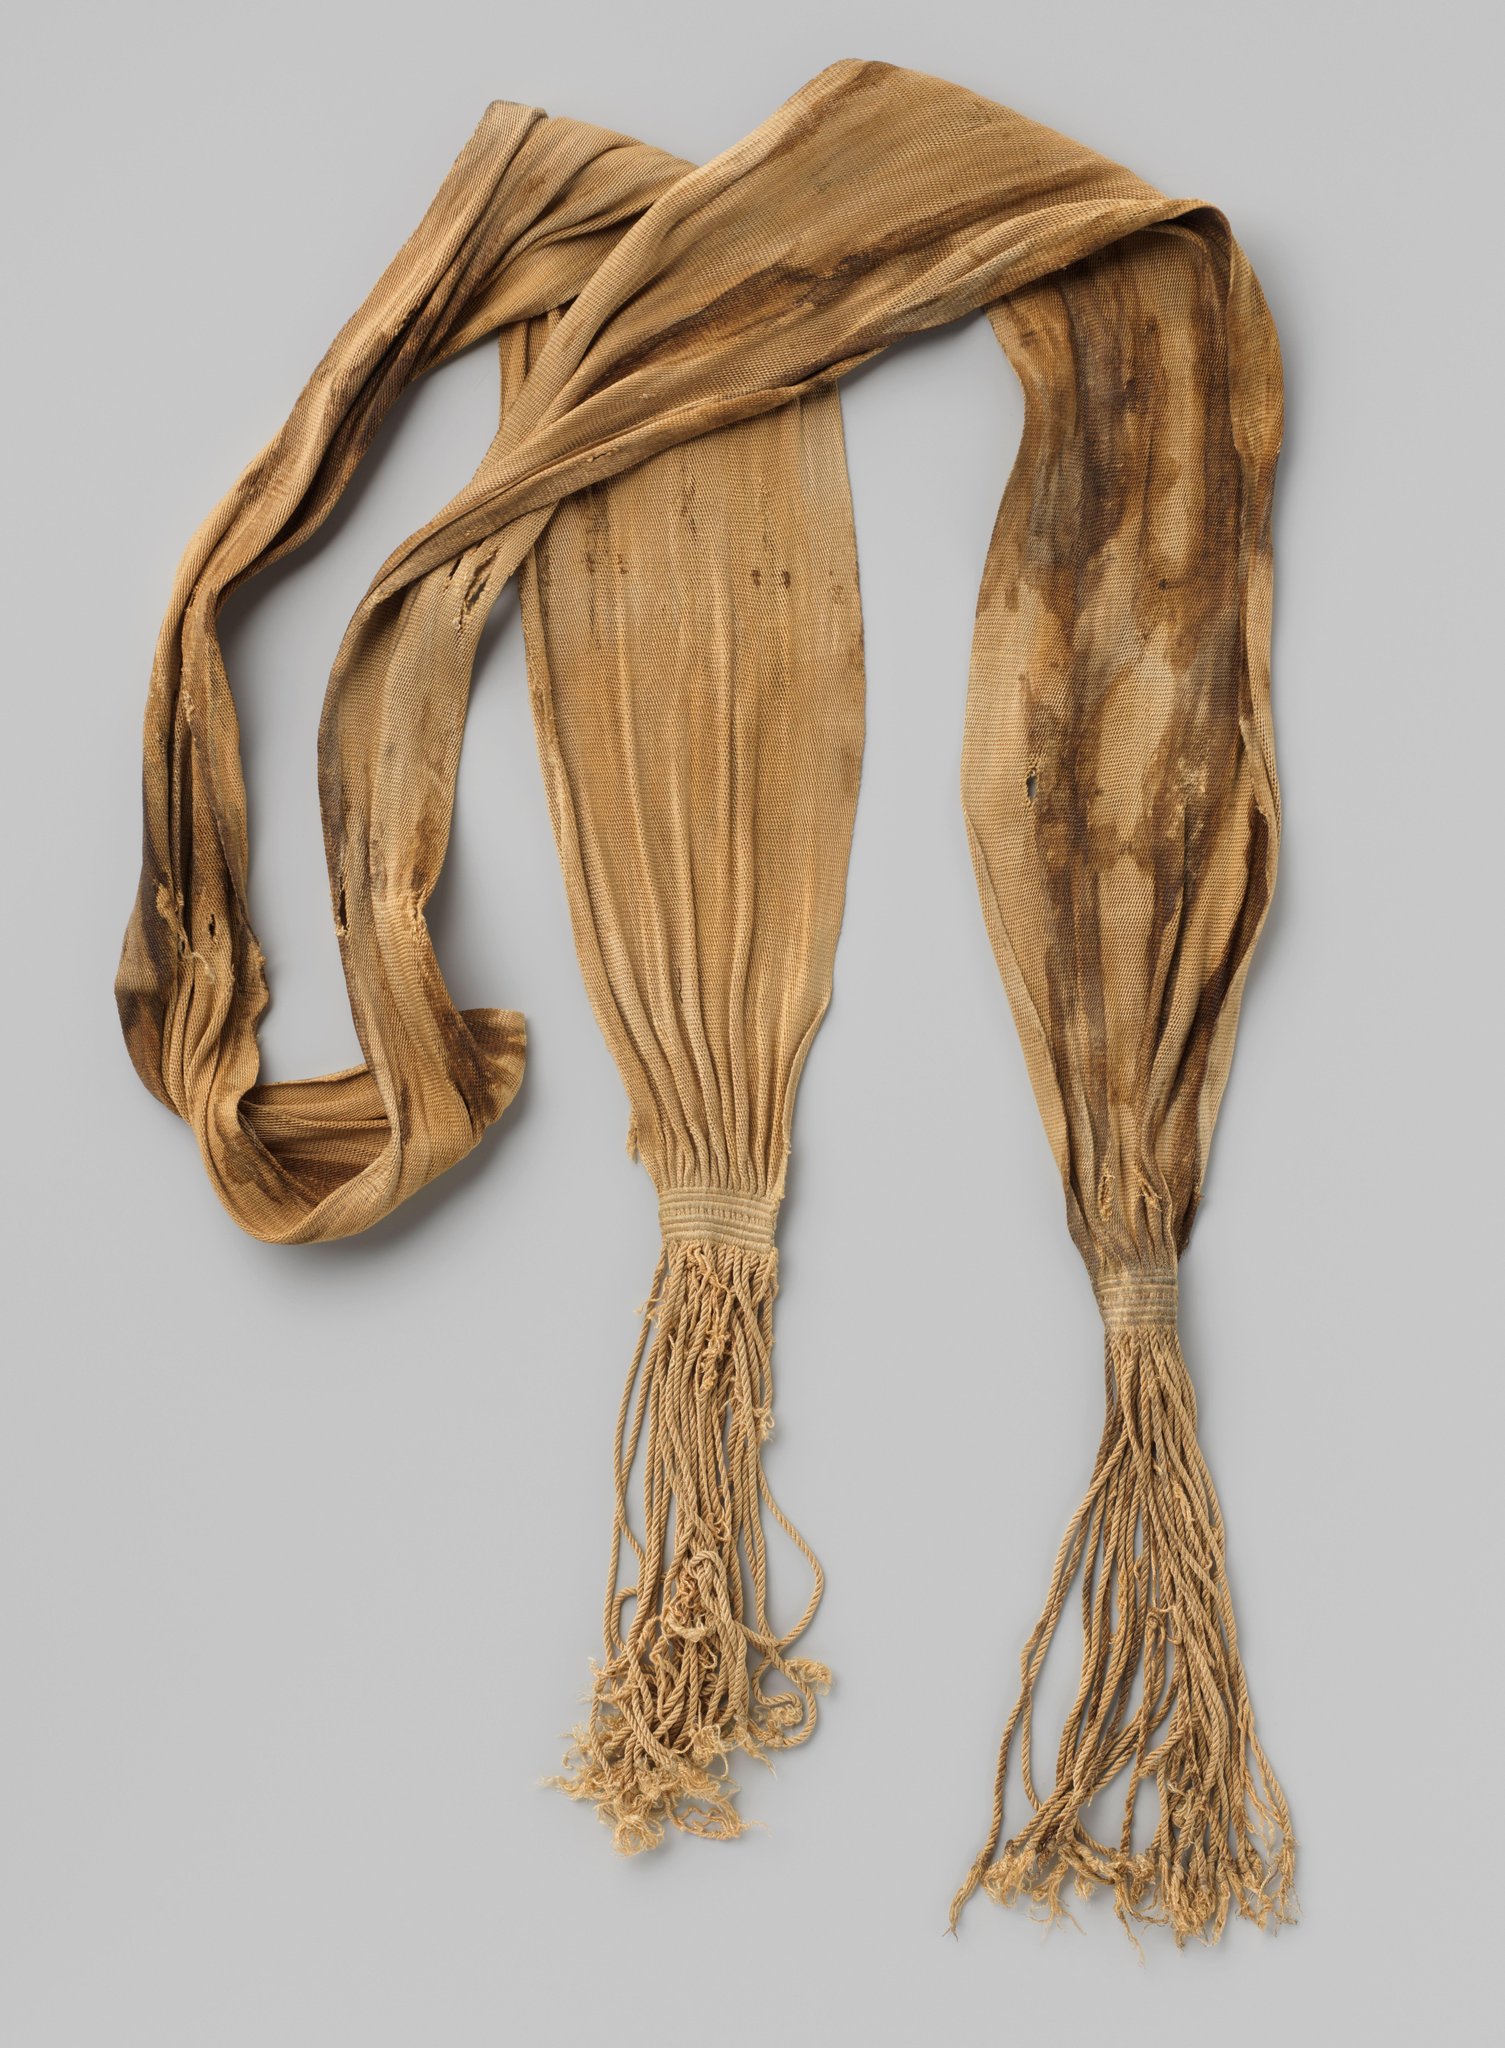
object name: sash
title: Sjerp gedragen door kapitein van Hoeg Schilthouwer van Oostee, gesneuveld op de citadel van Antwerpen op 13 December 1832.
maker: Anonymous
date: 1800-1830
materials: blood, silk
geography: netherlands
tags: van hoeg schilthouwer van oostee, citadel van antwerpen (19e eeuw), strijd om de citadel van antwerpen (1832), belgische revolutie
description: Een sjerp (met bloedvlekken) Kapitein van Hoey Schilthouwer van Oostee, gesneuveld op de Citadel van Antwerpen, 13 December 1832..